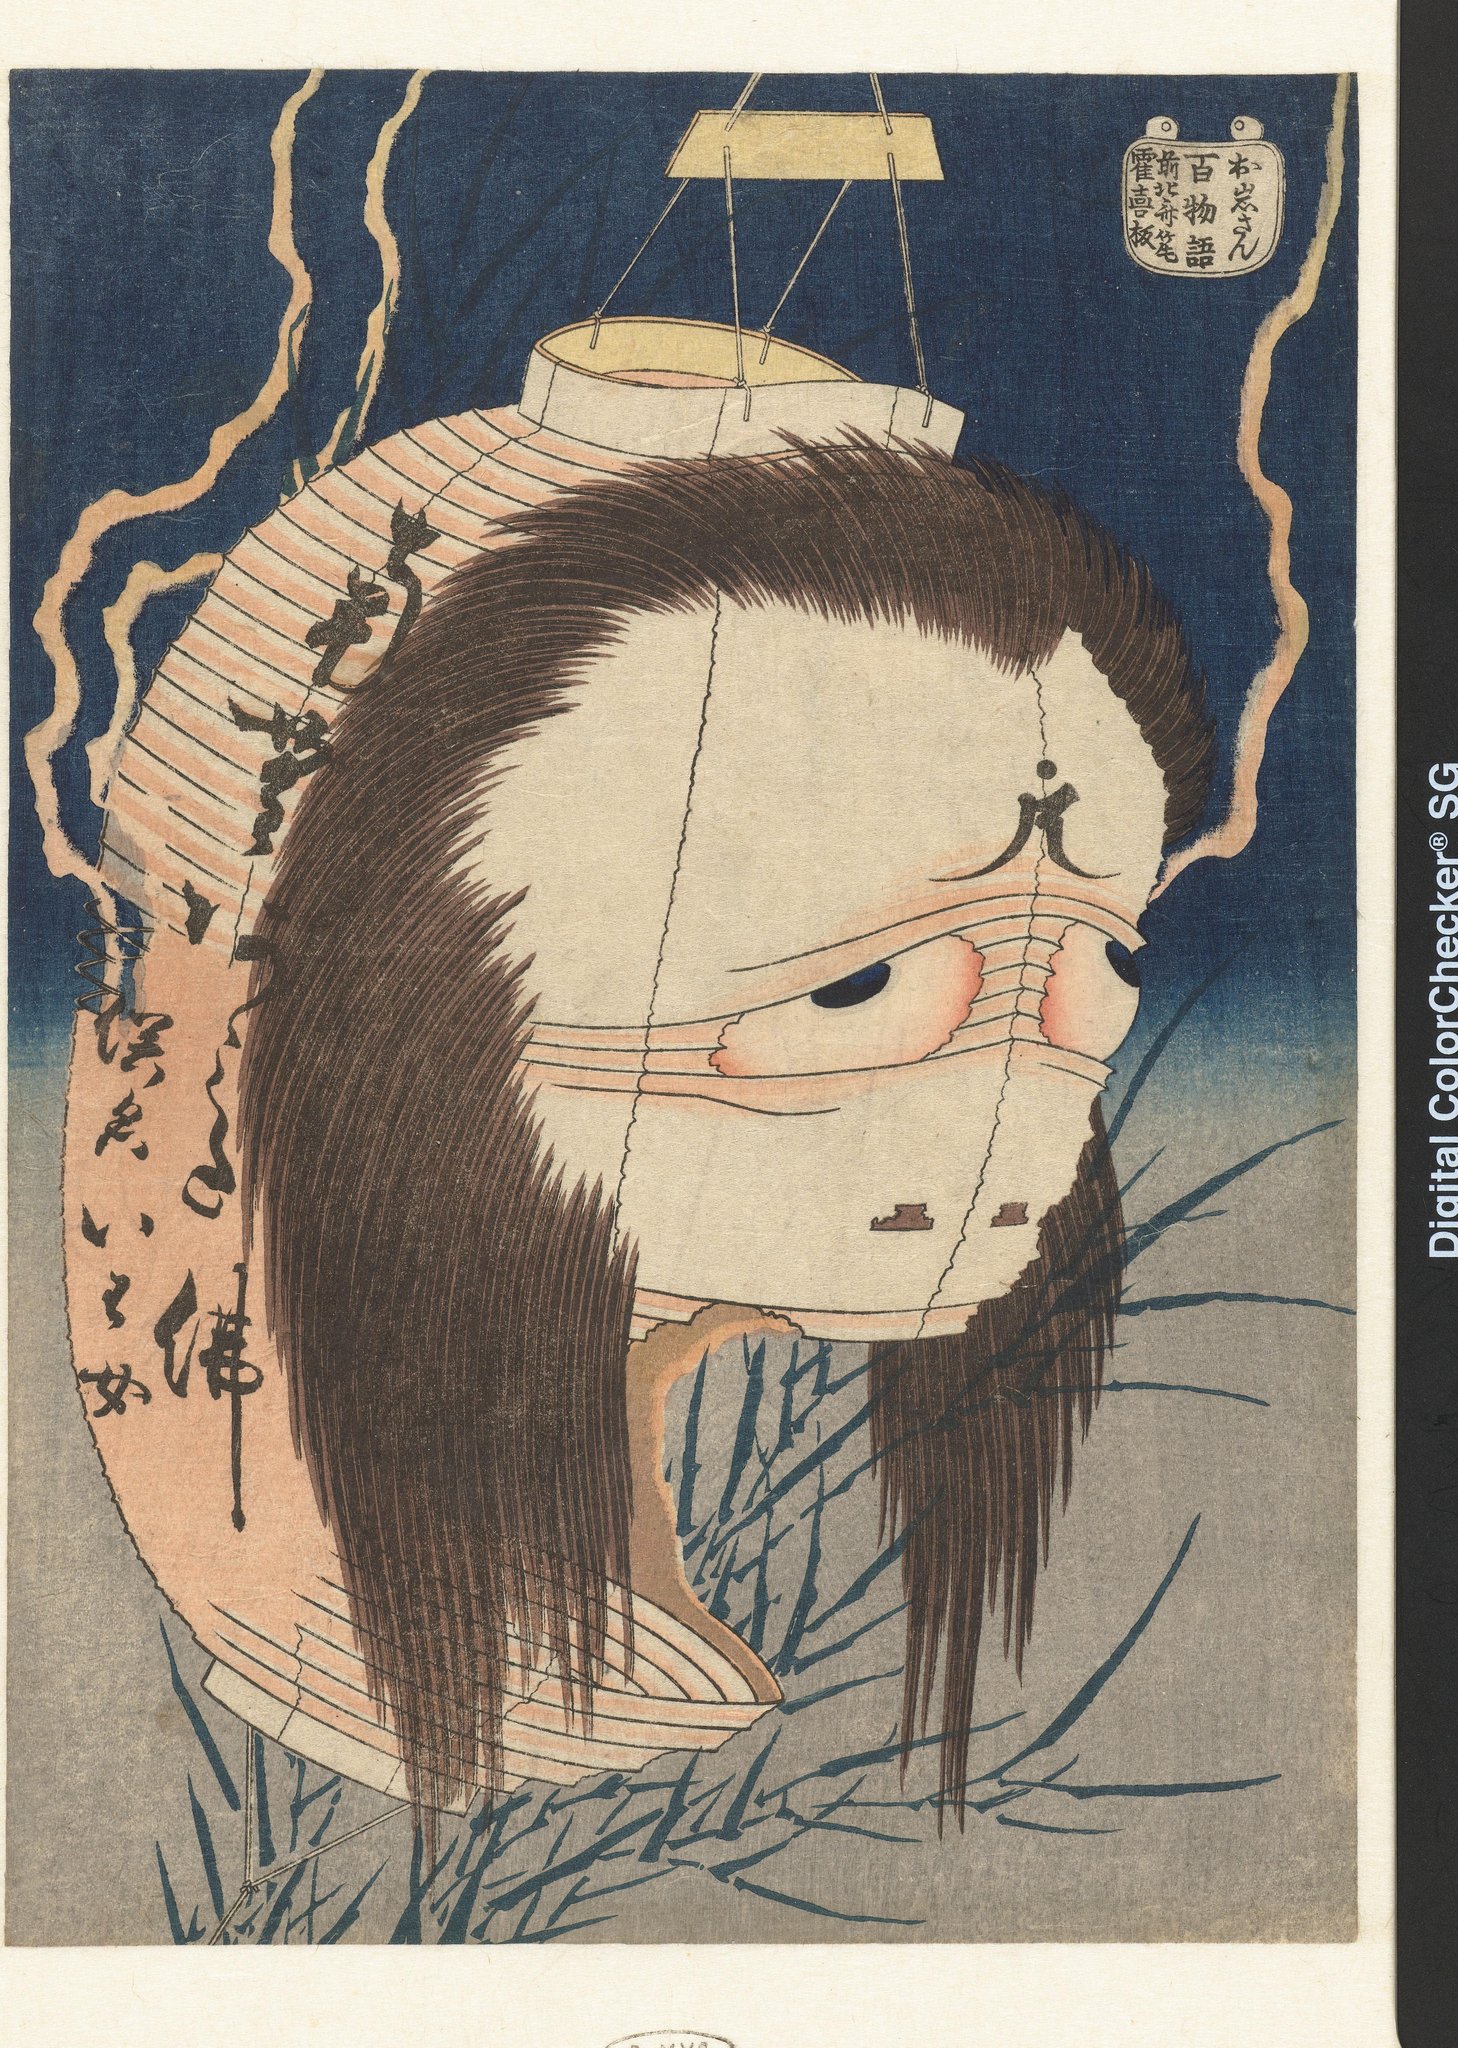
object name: print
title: Hyaku monogatari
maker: katsushika hokusai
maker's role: draughtsman, print maker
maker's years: 1760-1849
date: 1830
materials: paper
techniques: woodcut, nishiki e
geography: japan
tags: lantern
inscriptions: collector's mark: Lugt 2228